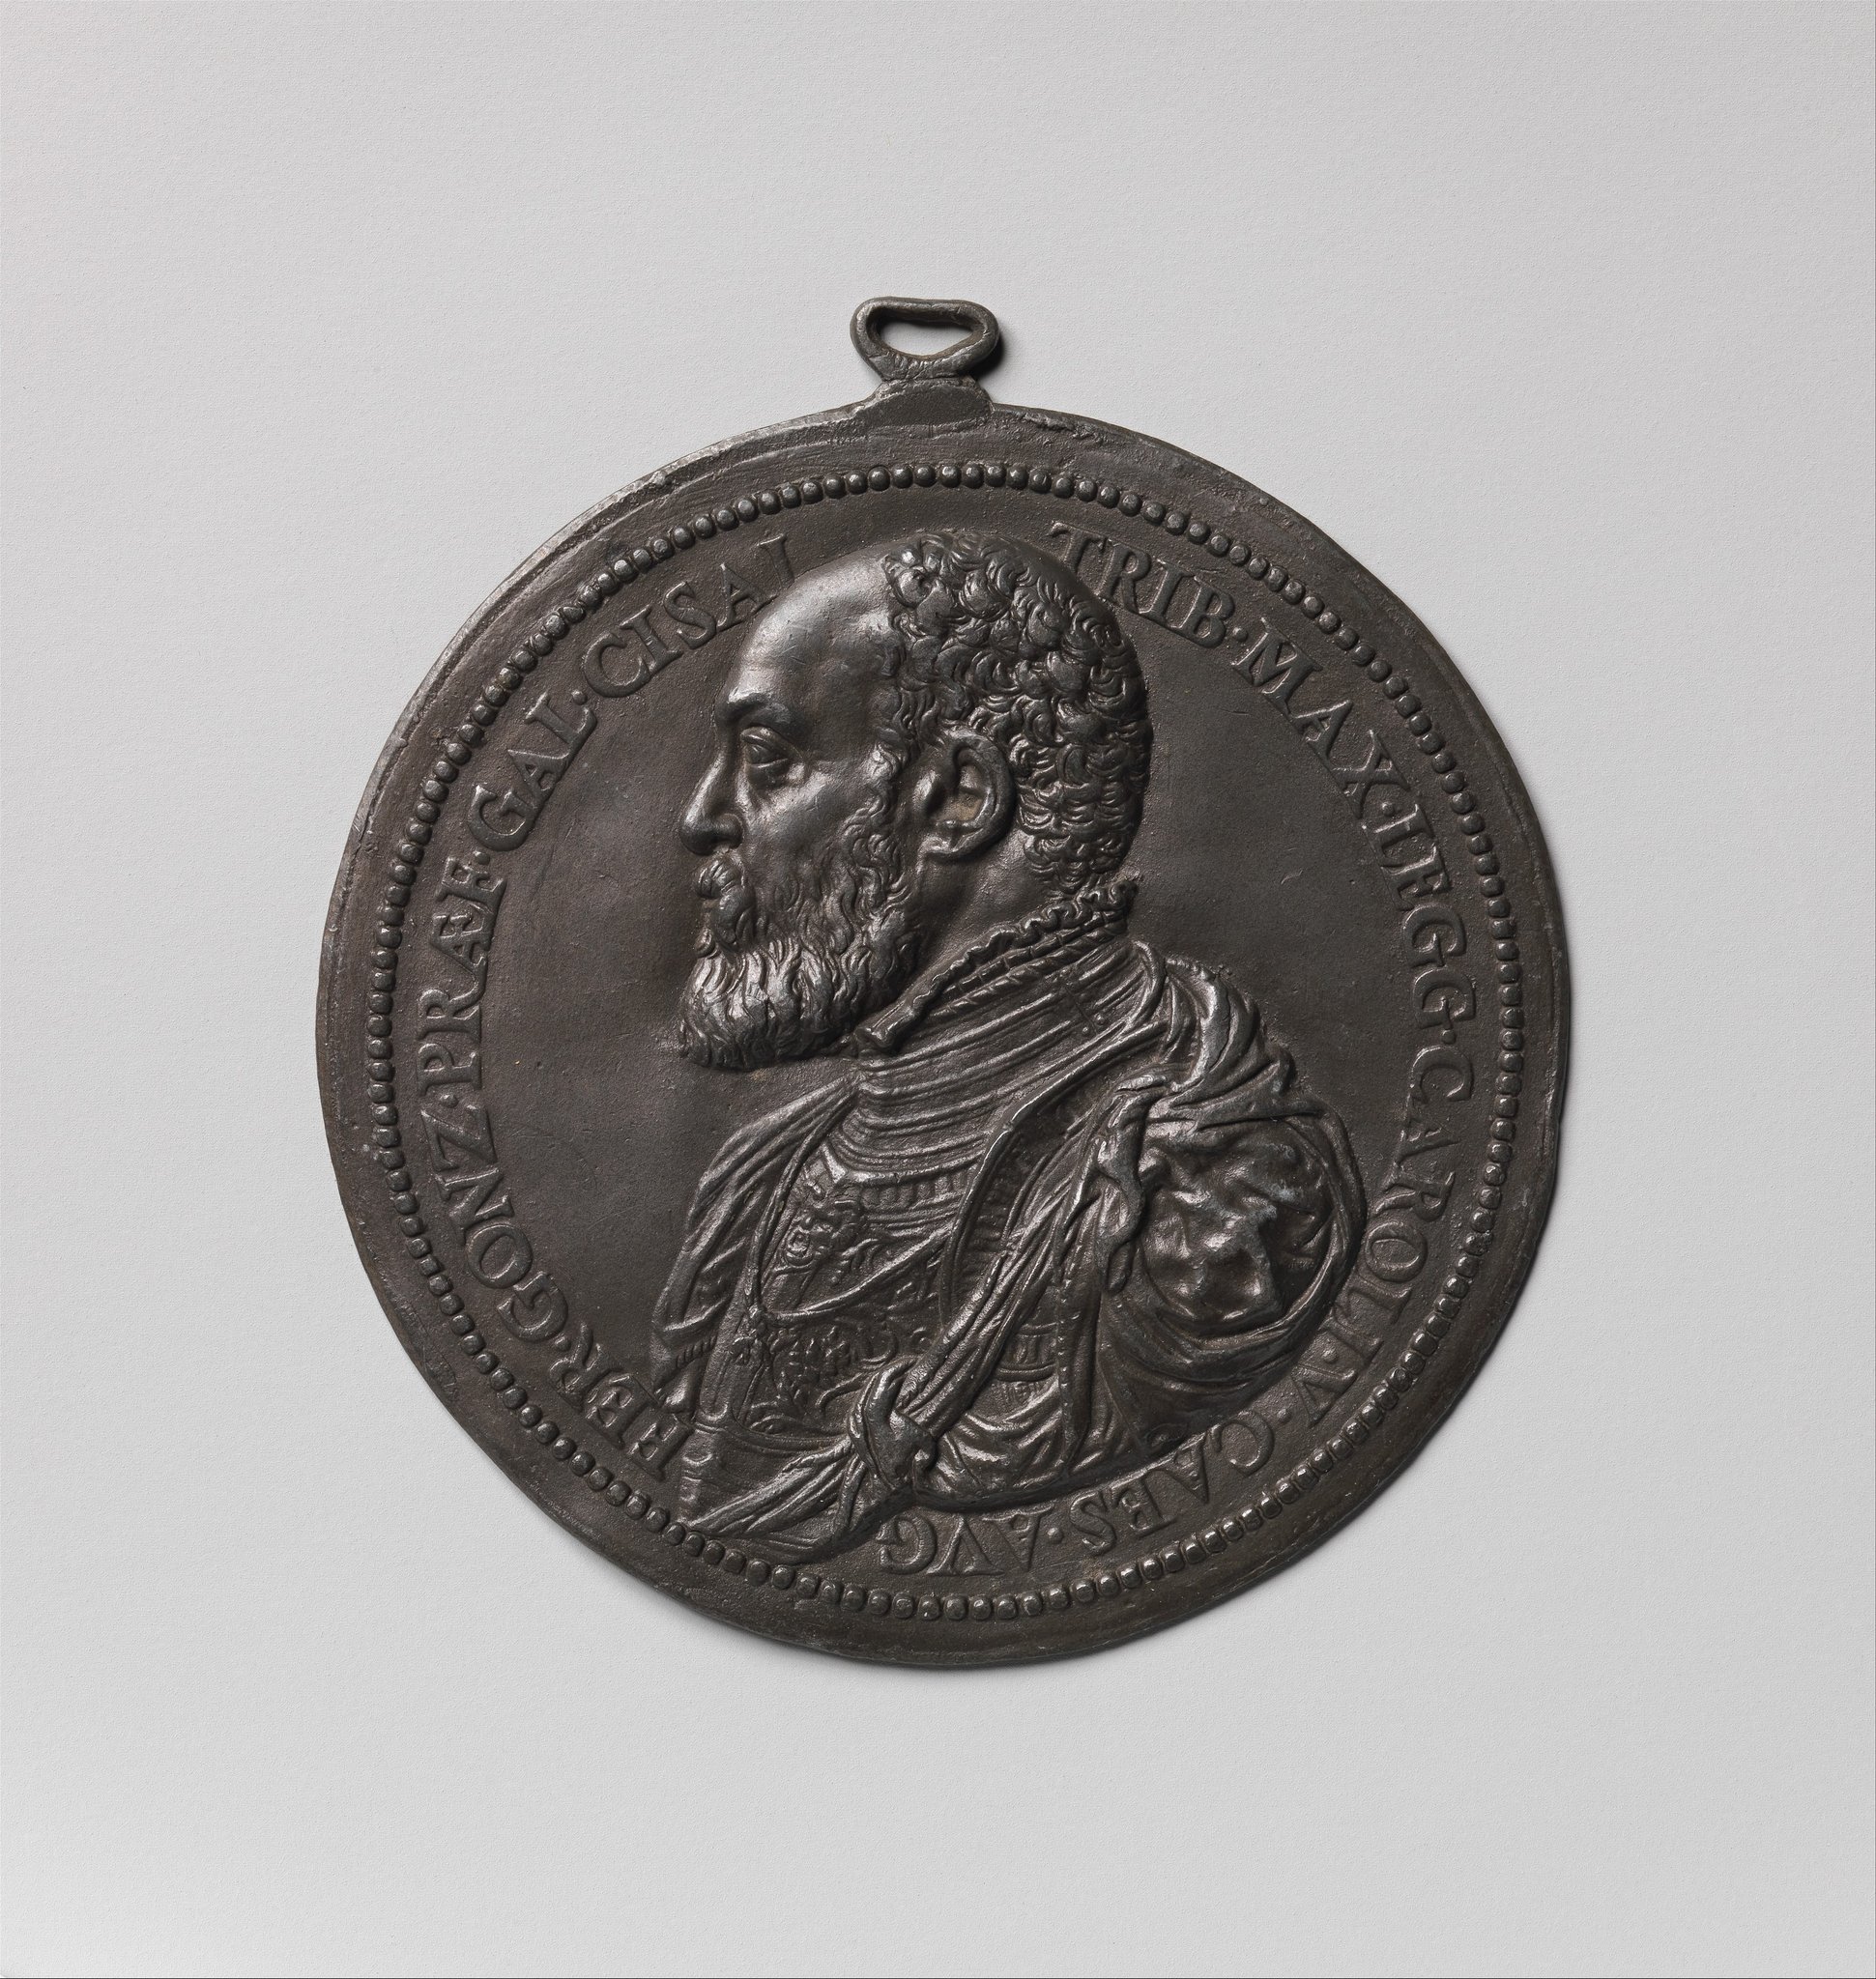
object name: medal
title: Ferrante Gonzaga, Count of Guastalla (1506–1557)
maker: leone leoni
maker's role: artist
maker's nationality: italian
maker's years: 1504-1590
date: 1555-1556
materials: lead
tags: men,profiles